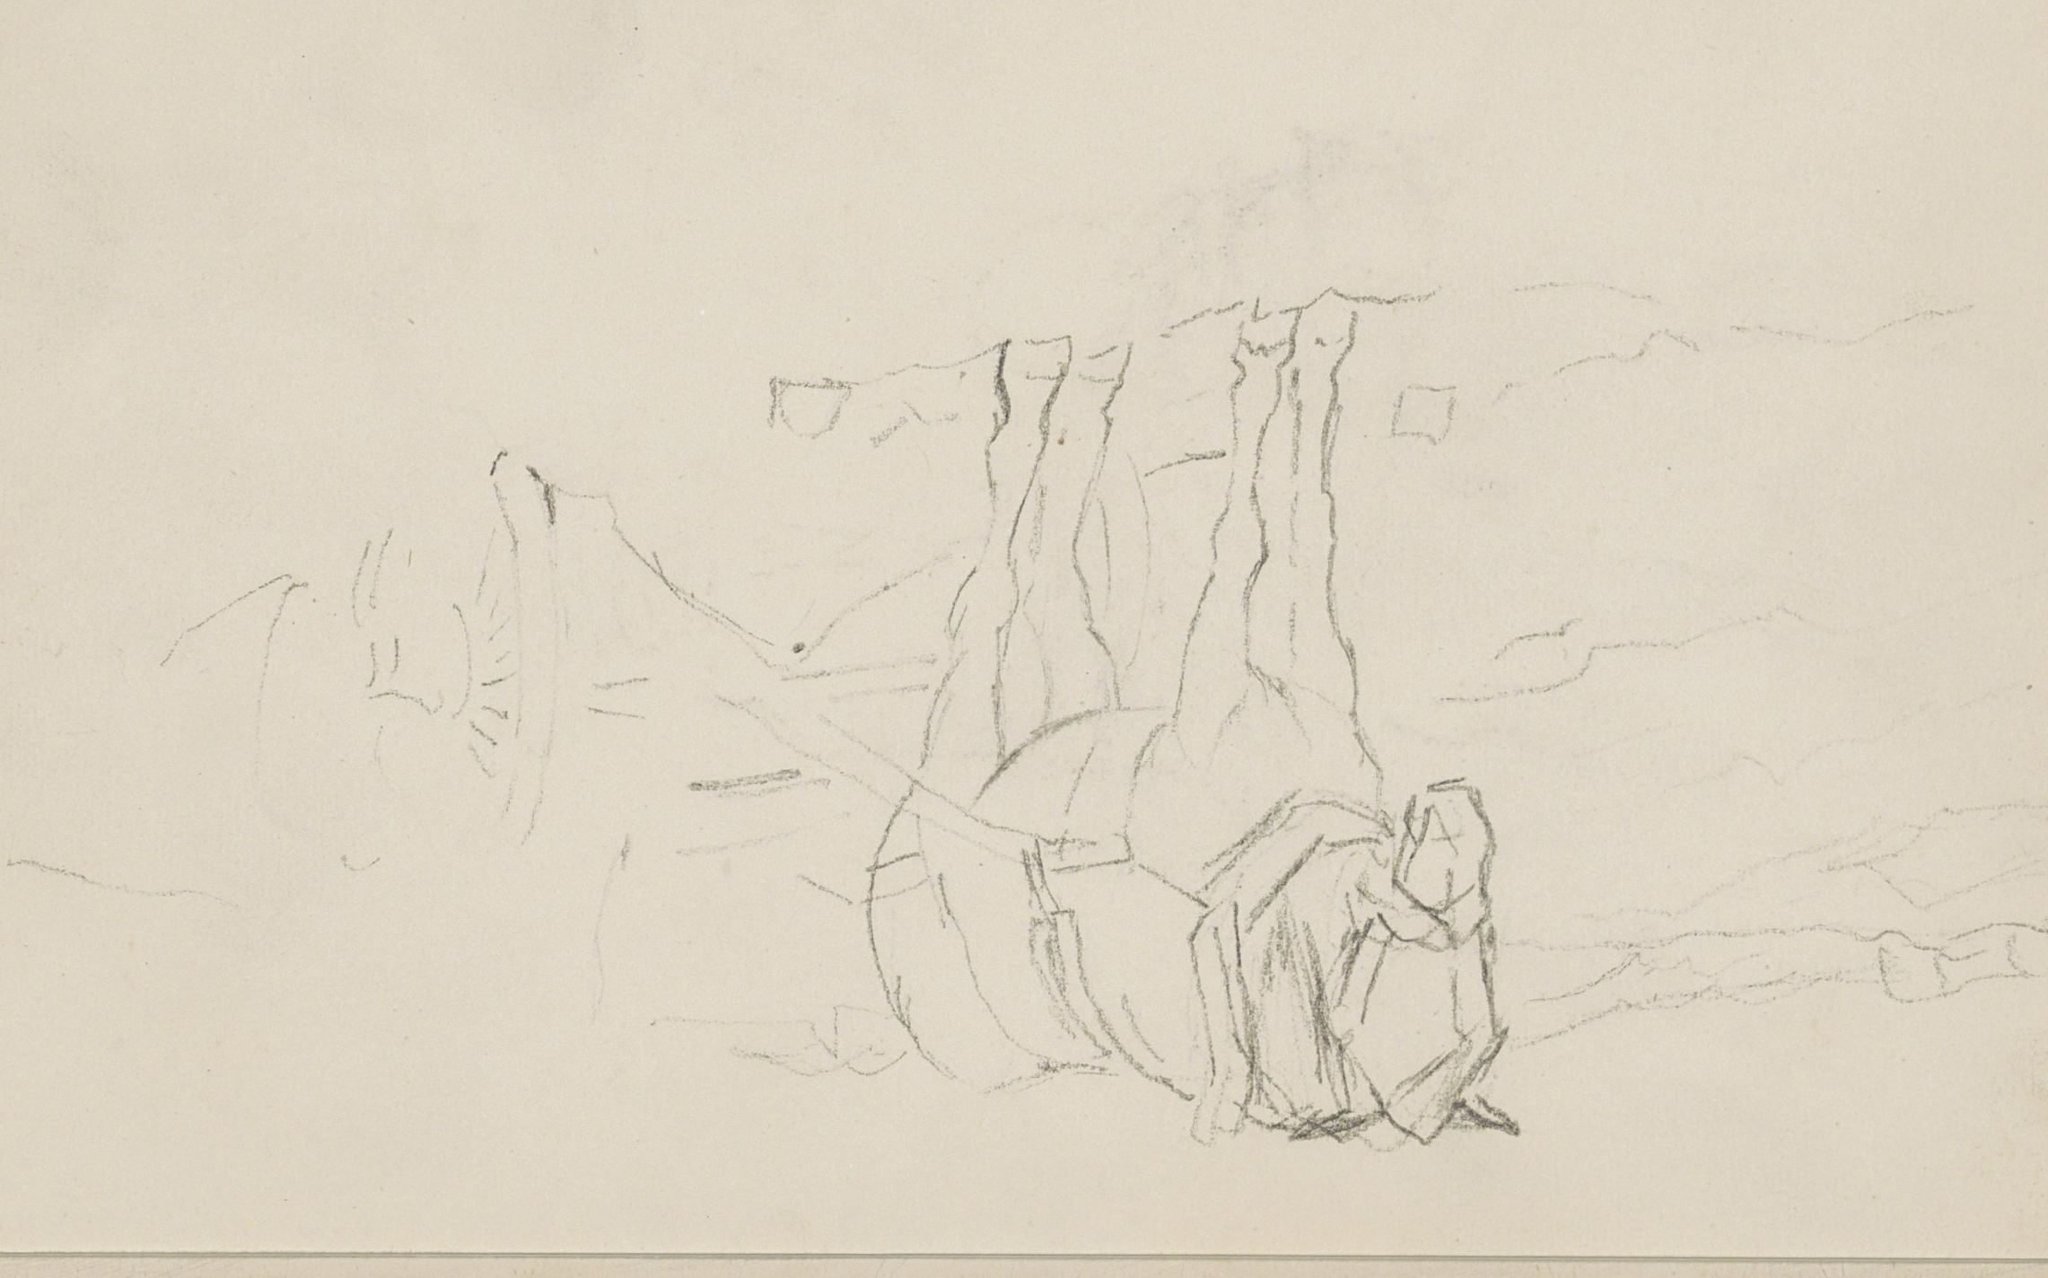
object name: sketchbook leaf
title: Ploegend paard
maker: anton mauve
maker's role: draughtsman, painter, print maker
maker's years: 1838-1888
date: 1848-1888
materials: paper, pencil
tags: horse, ploughing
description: Blad 13 recto uit een schetsboek met 42 bladen.